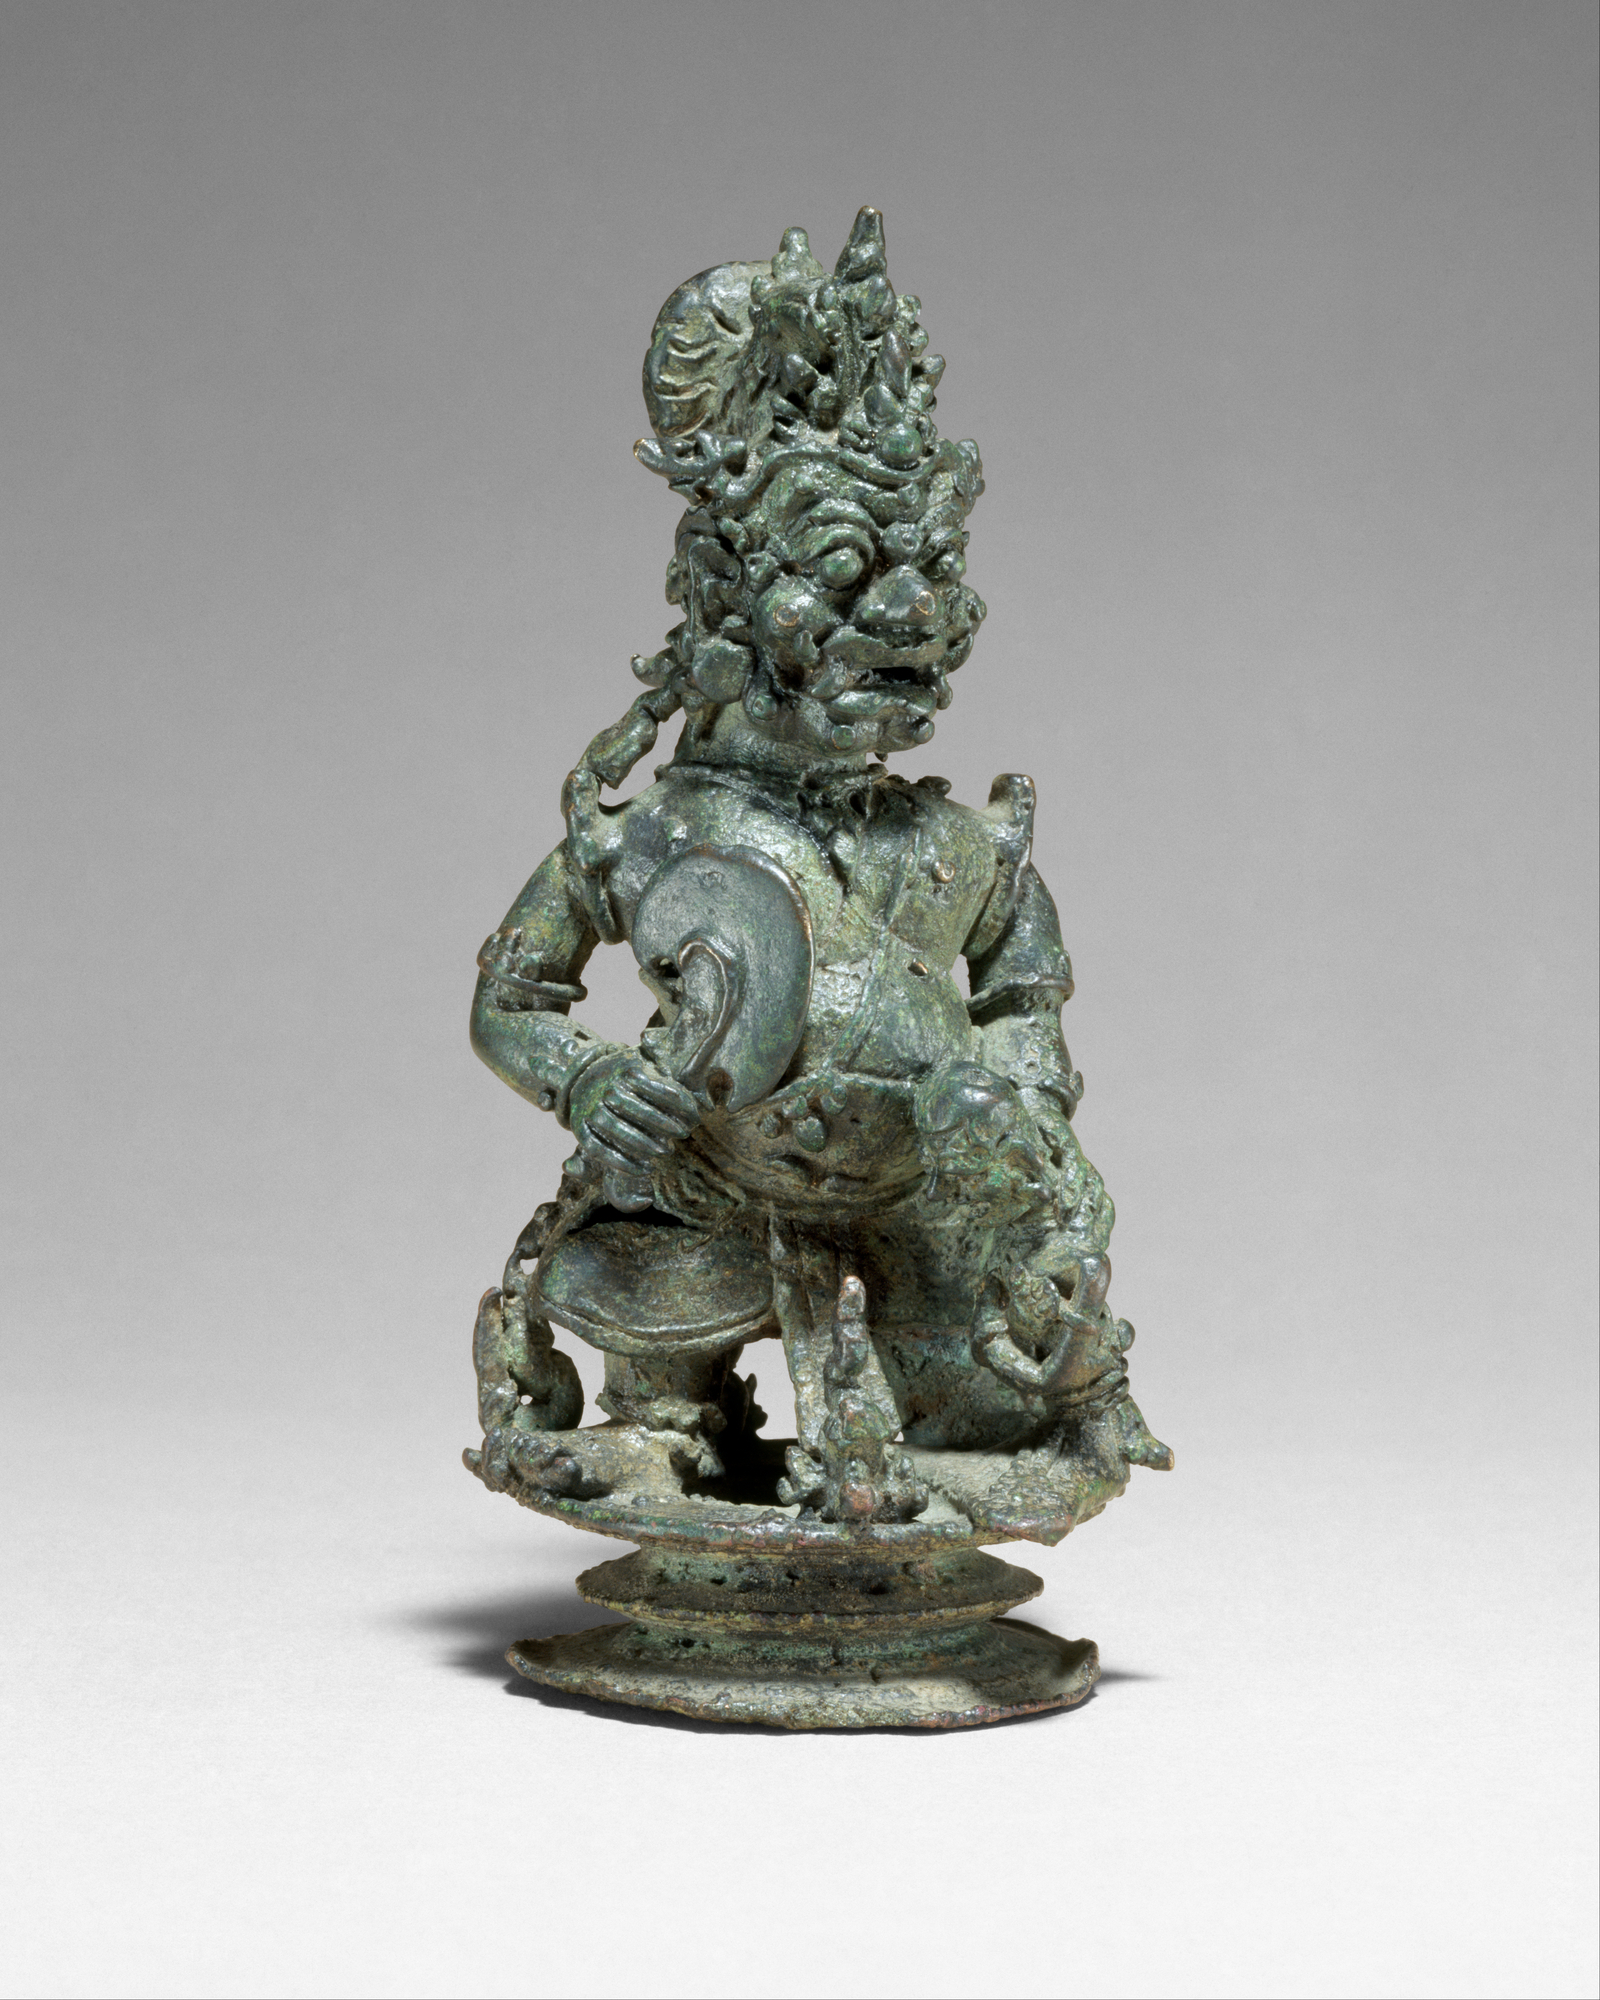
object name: bell top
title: Top of a Bell in the Form of a Demon King or Guardian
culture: indonesian, javanese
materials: bronze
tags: demons